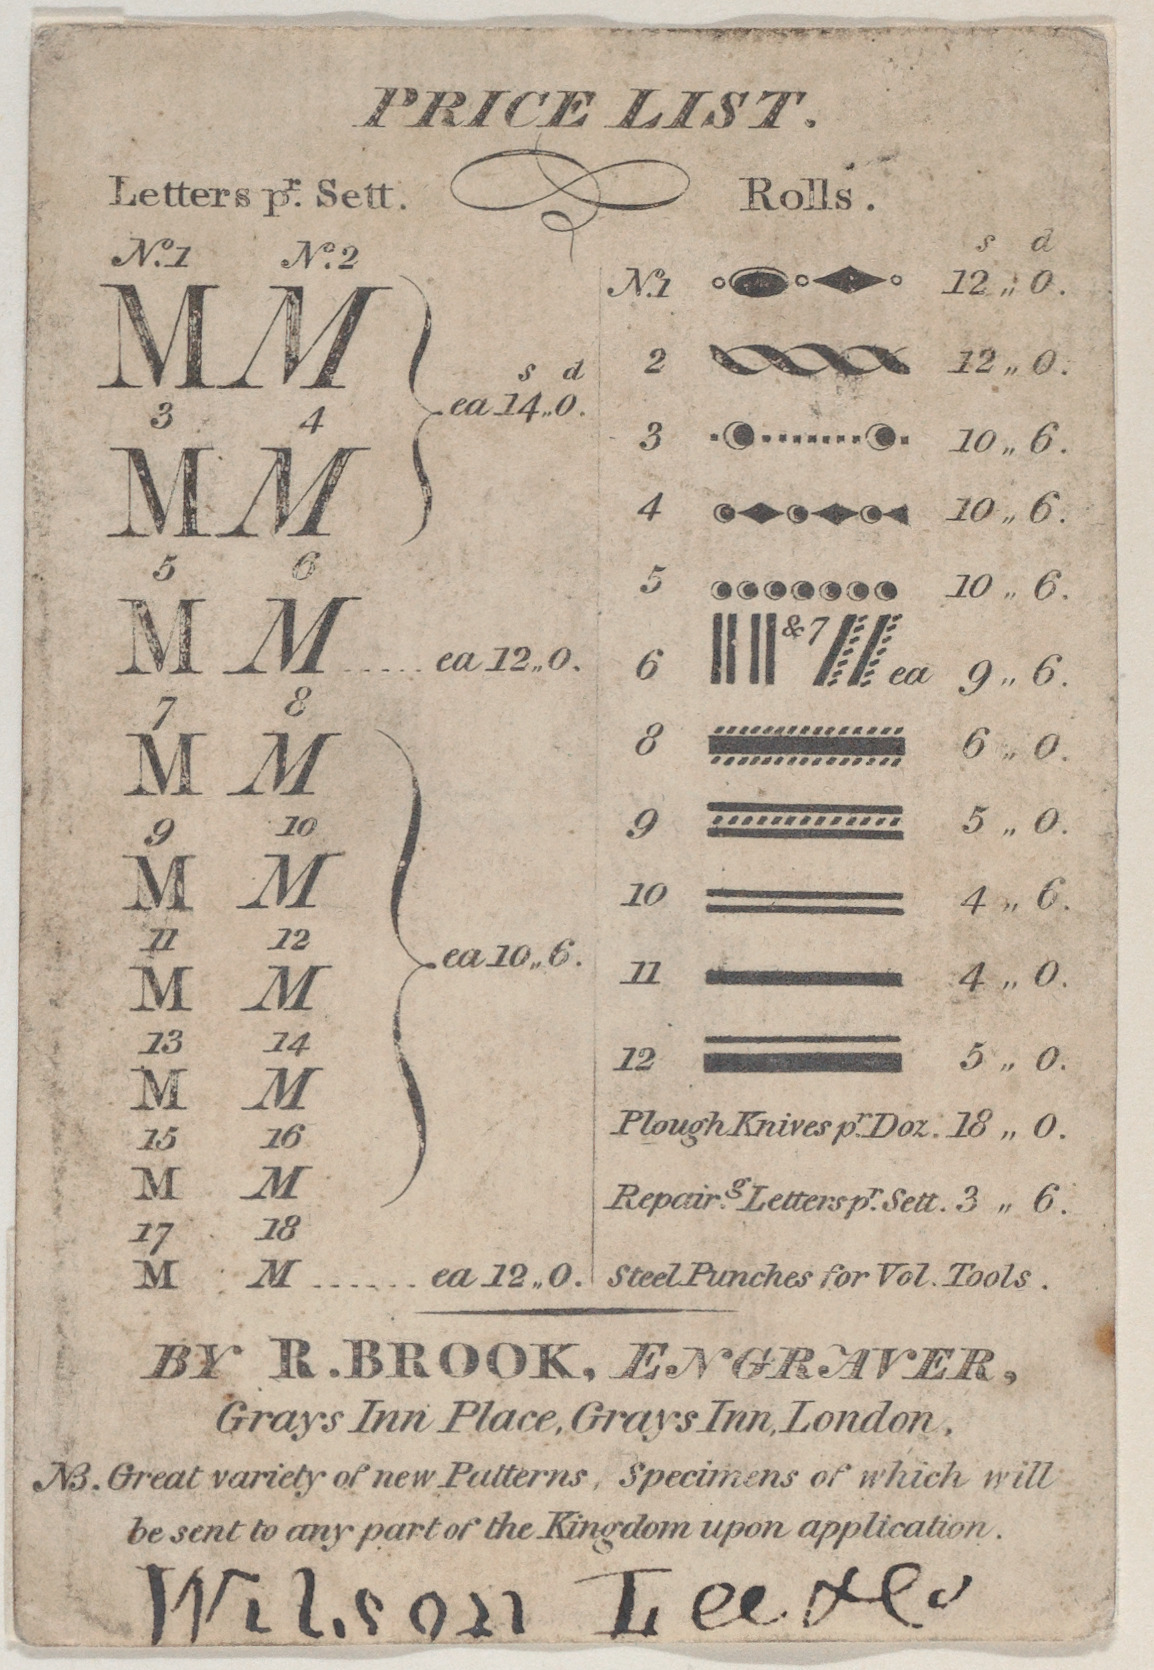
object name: print, trade card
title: Trade Card for R. Brook, Engraver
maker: anonymous, british, 19th century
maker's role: artist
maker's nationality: british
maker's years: 1800-1900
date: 1801-1900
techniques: engraving